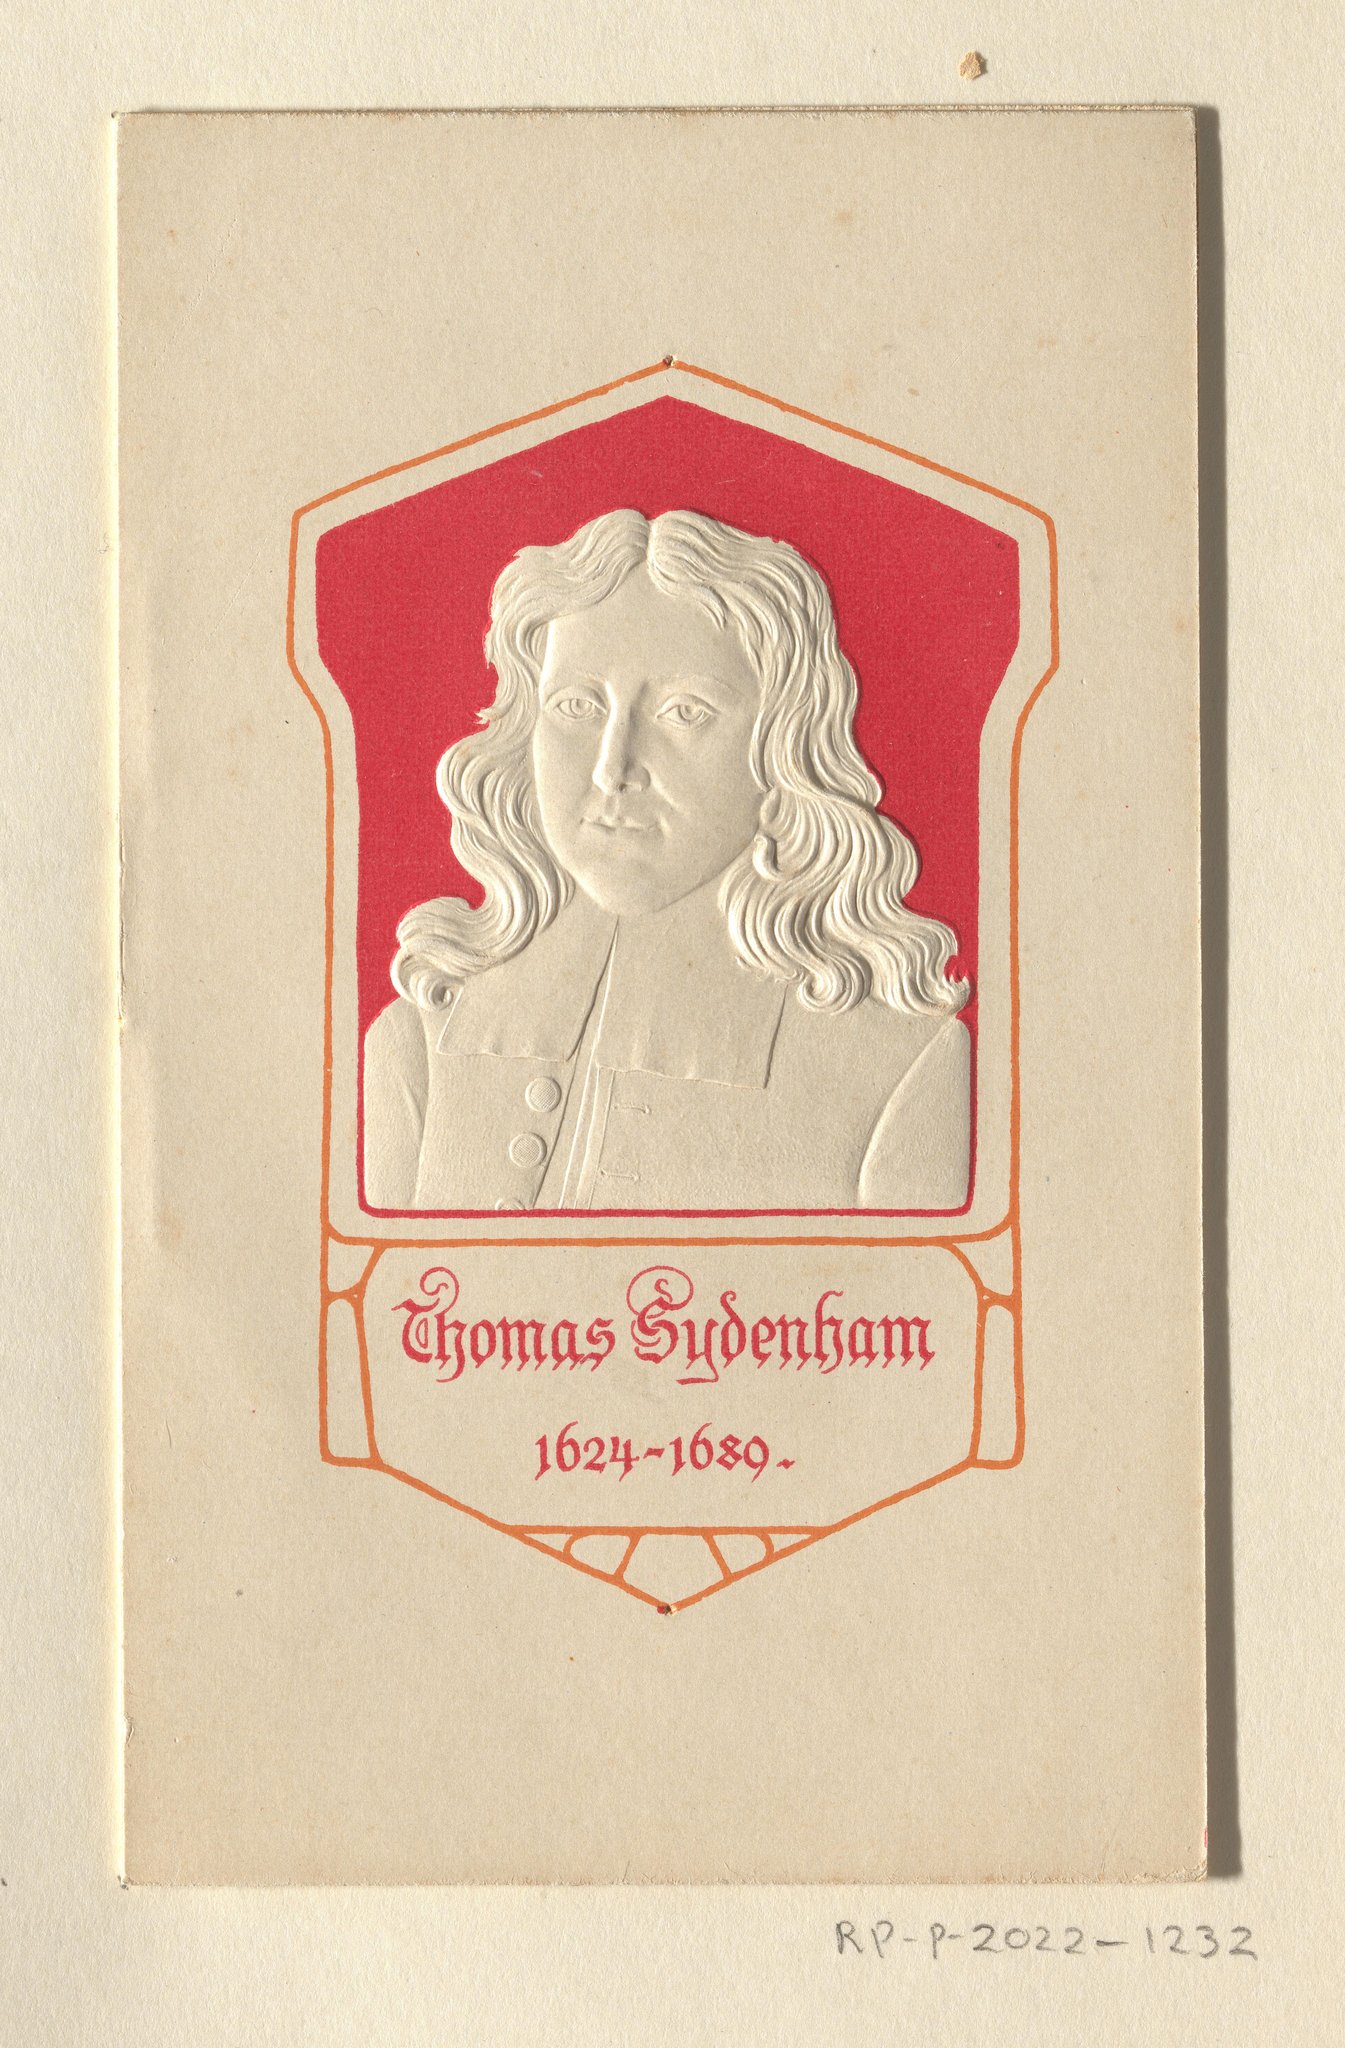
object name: print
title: Galerie berühmter Ärzte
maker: Anonymous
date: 1910-1915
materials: paper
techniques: blind stamped, lithograph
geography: germany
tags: advertising, physician, doctor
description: Kaart met portretbuste van de arts Thomas Sydenham. Onderdeel van de serie kaarten in reliëfdruk uitgebracht als reclame voor de medische producten van Tropon-Werke, Mülheim am Rhein.